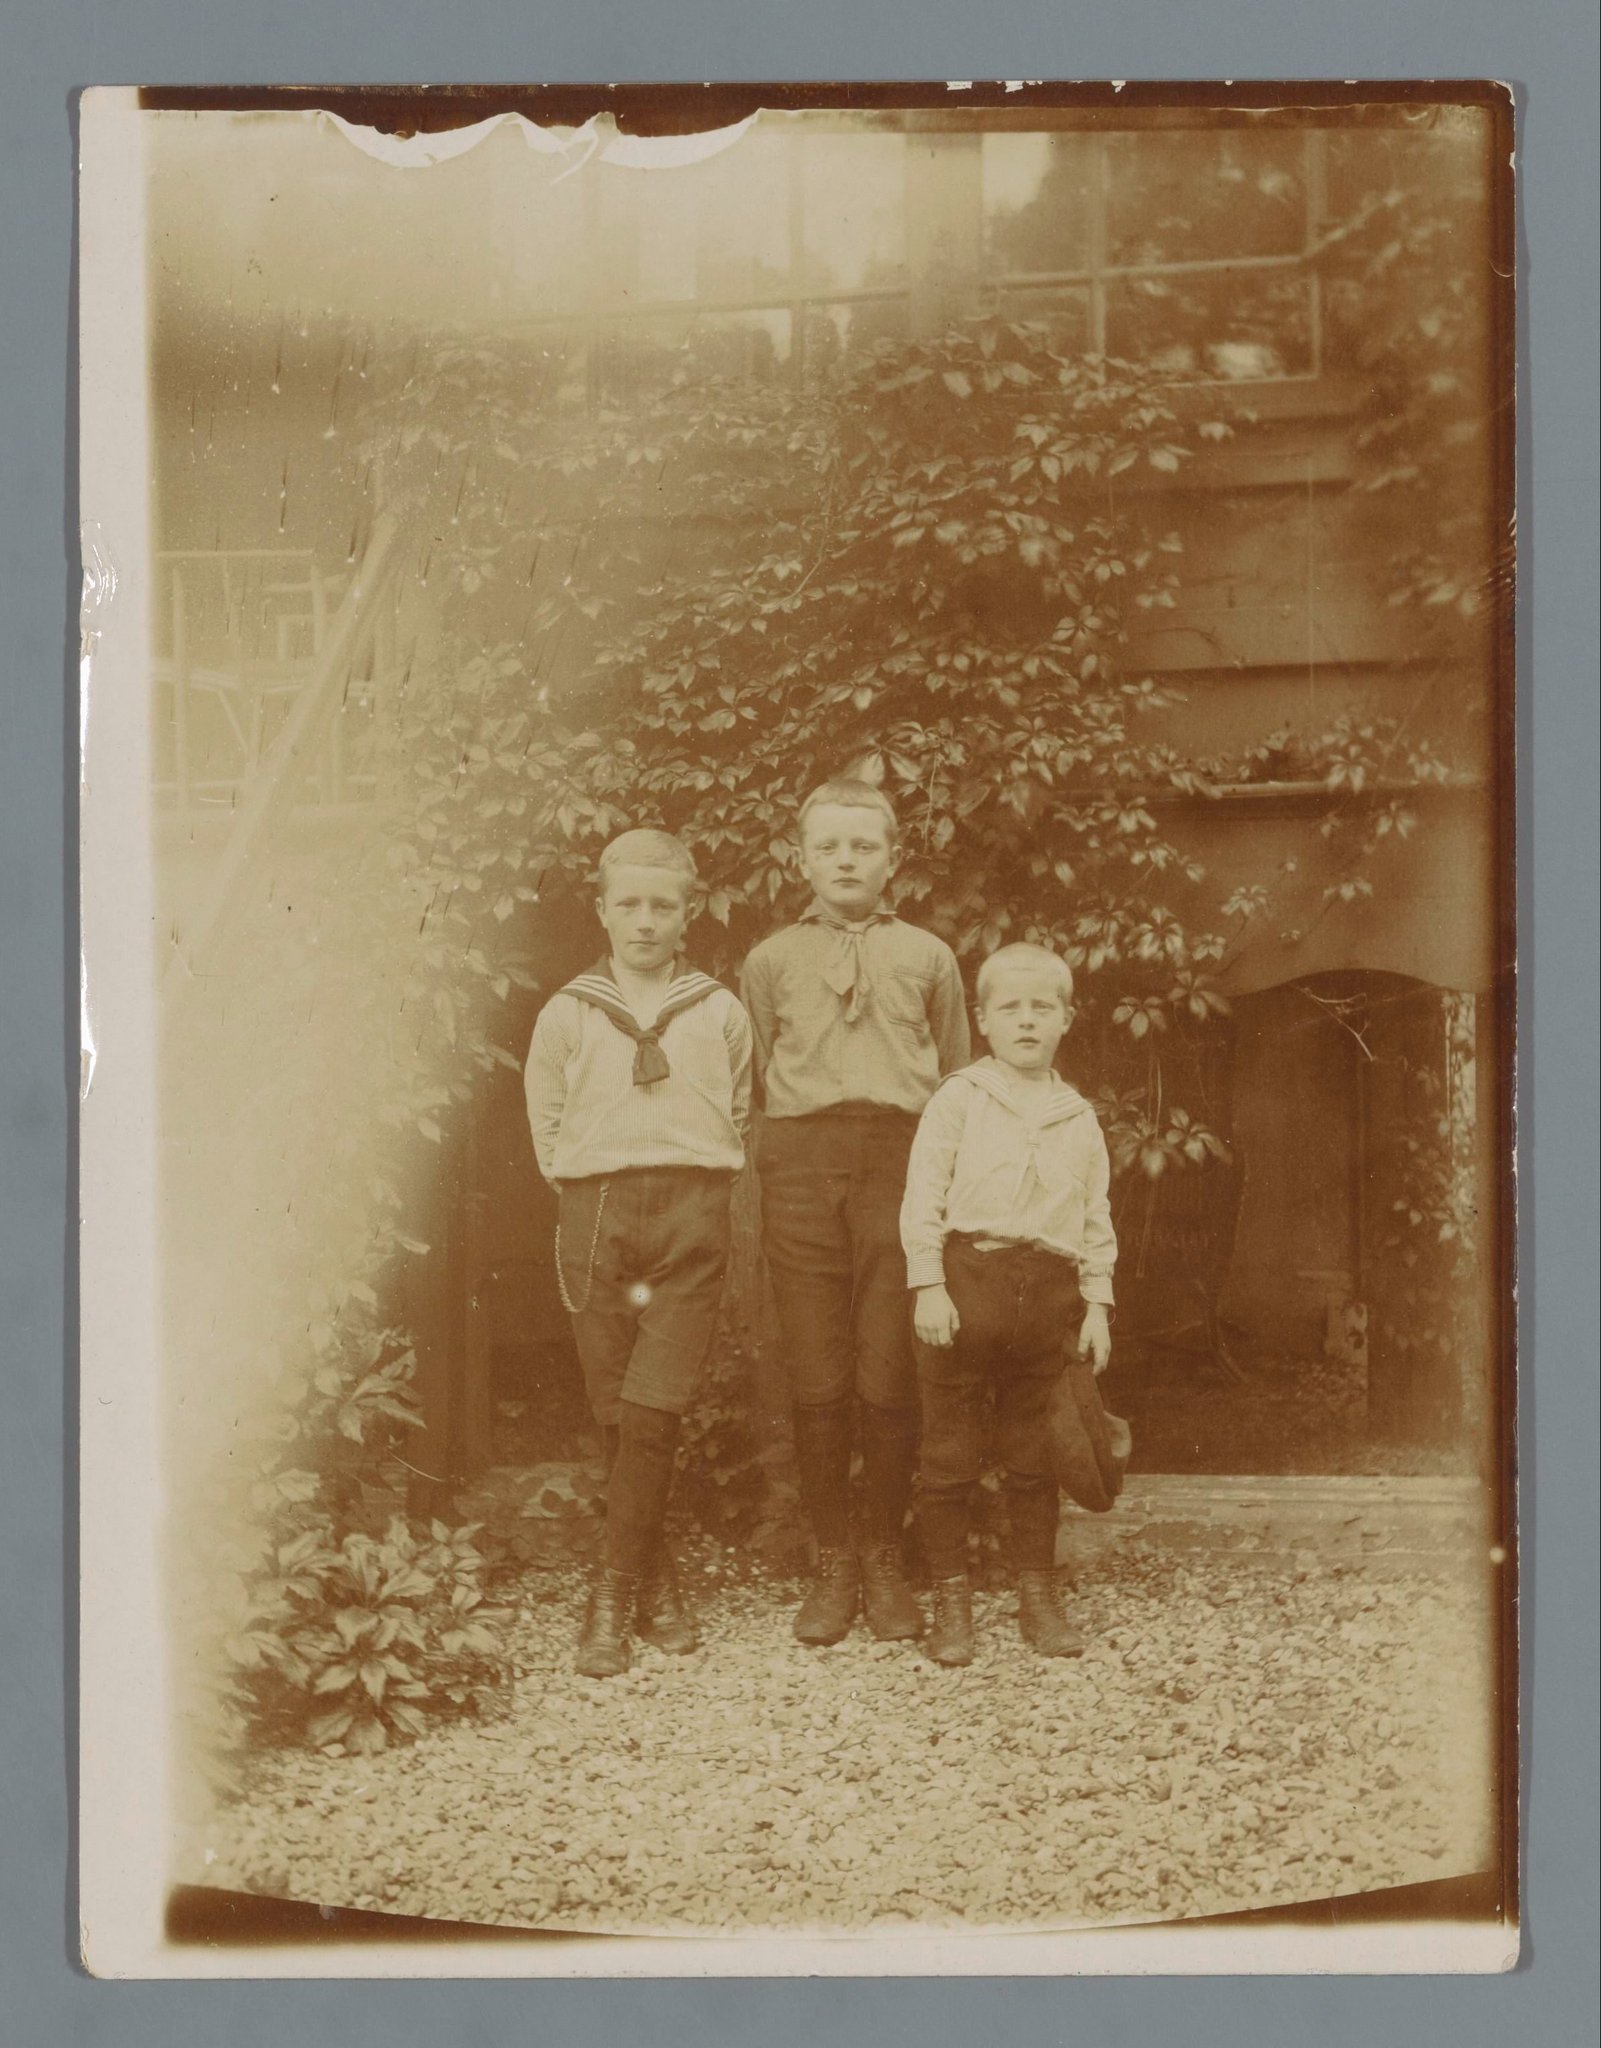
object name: photograph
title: Portret van drie onbekende jongens in een tuin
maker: Anonymous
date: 1905-1910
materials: photographic support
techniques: gelatin silver print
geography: netherlands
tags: boy (child between toddler and youth), backyard